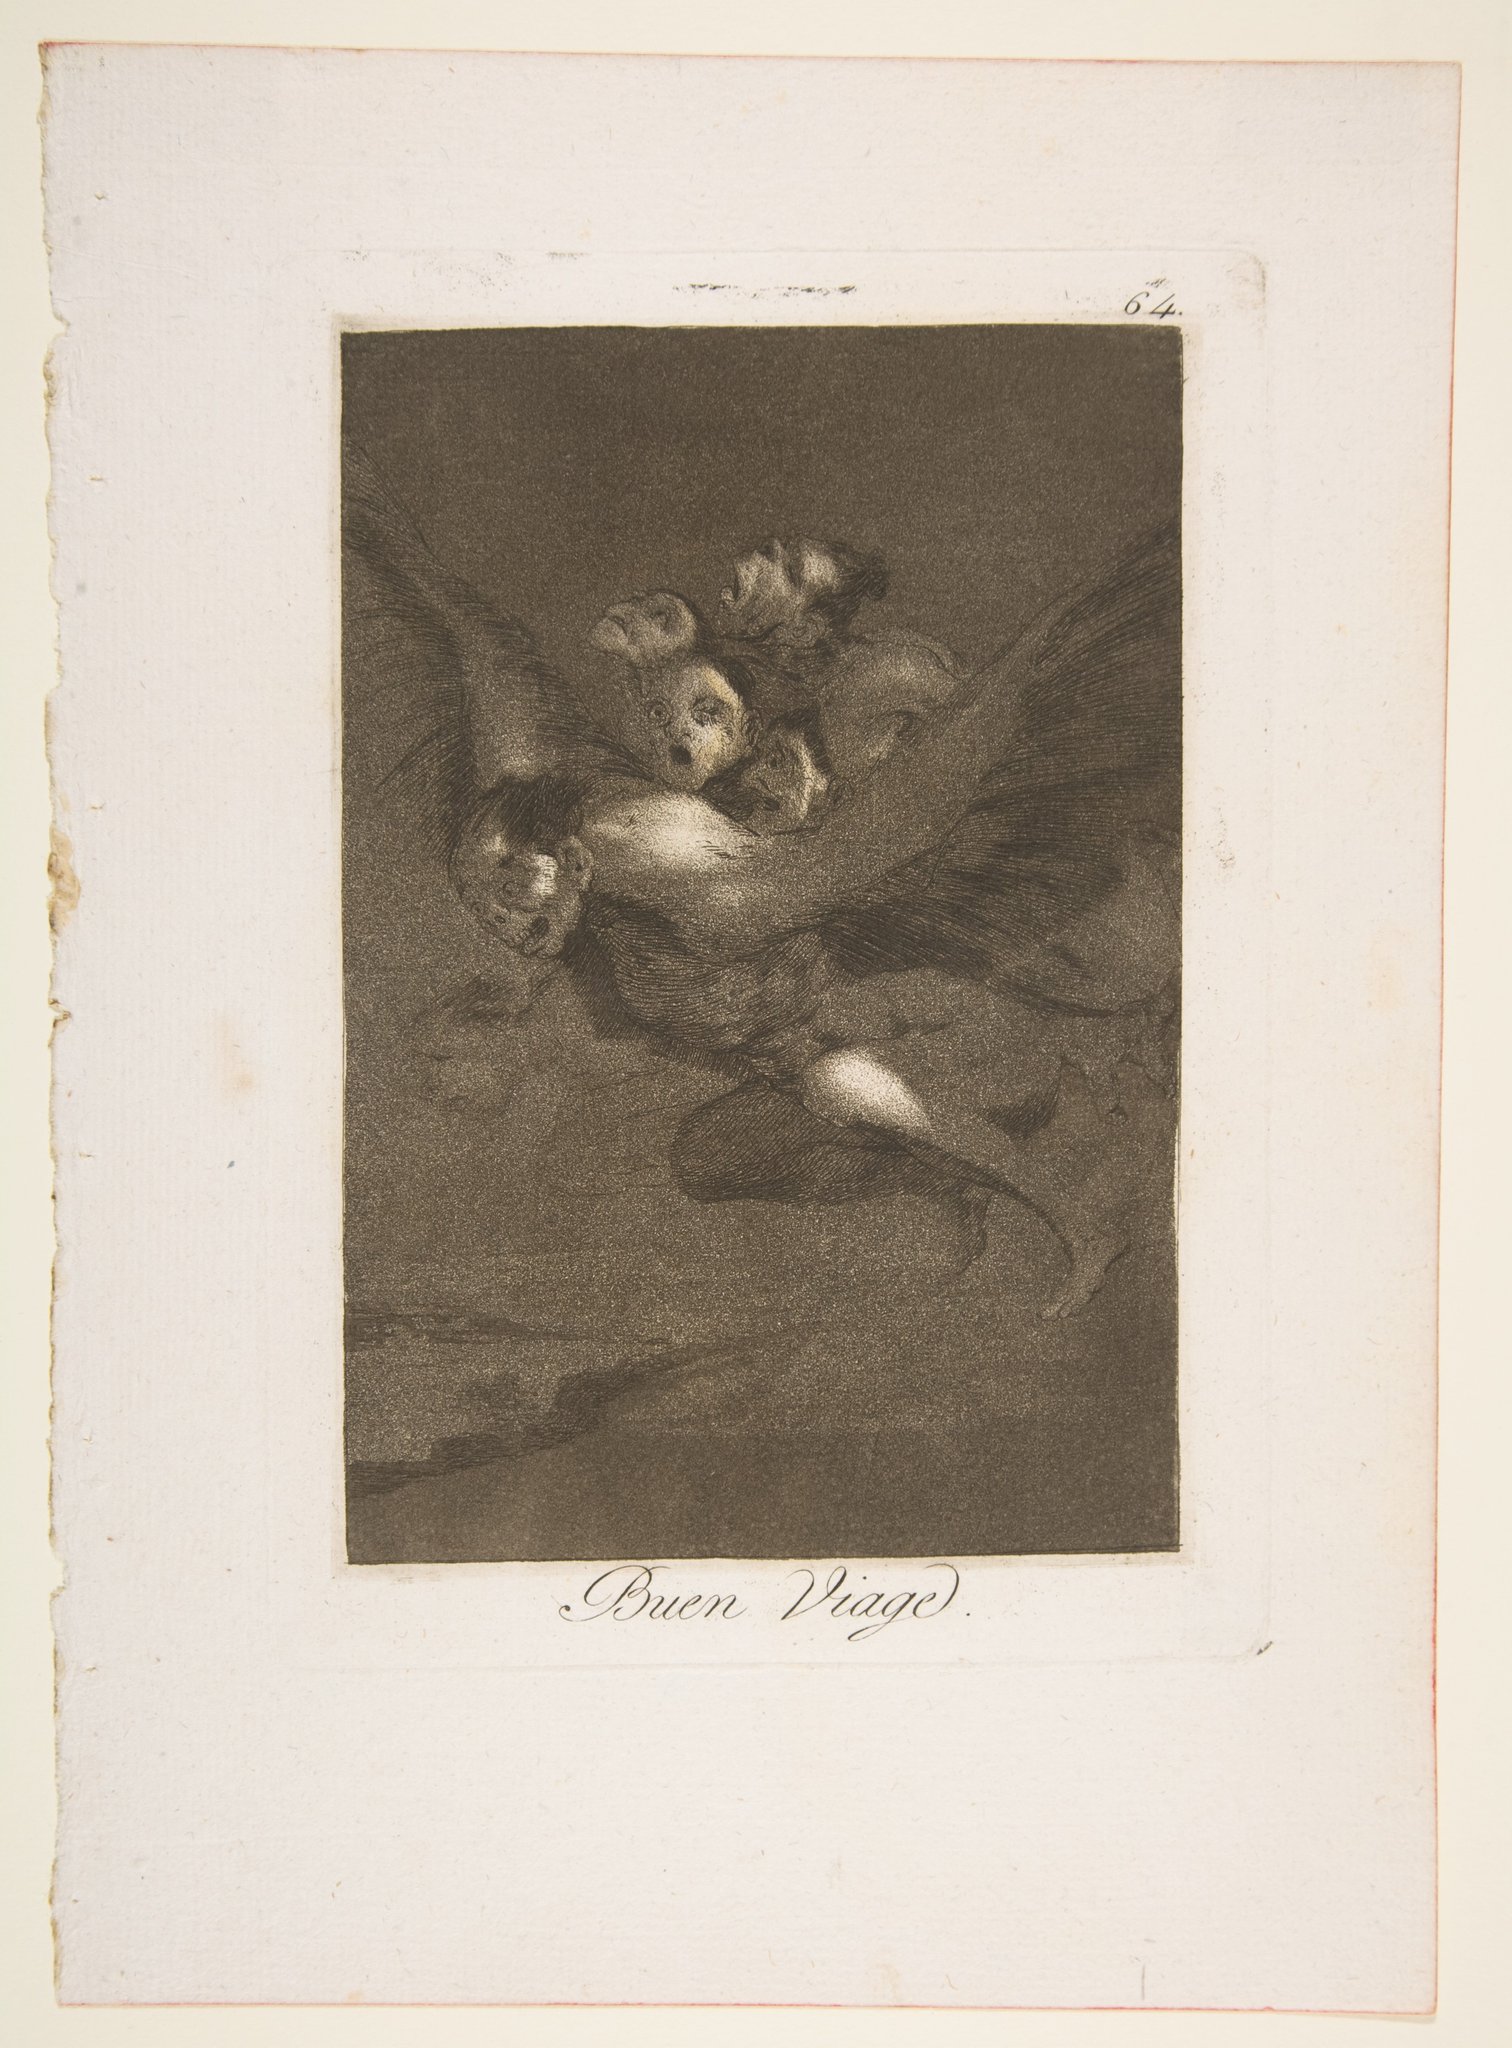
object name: print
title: Plate 64 from "Los Caprichos": Bon voyage (Buen Viage)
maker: goya (francisco de goya y lucientes)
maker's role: artist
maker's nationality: spanish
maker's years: 1746-1828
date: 1799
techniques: aquatint, engraving, burnishing, etching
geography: spain